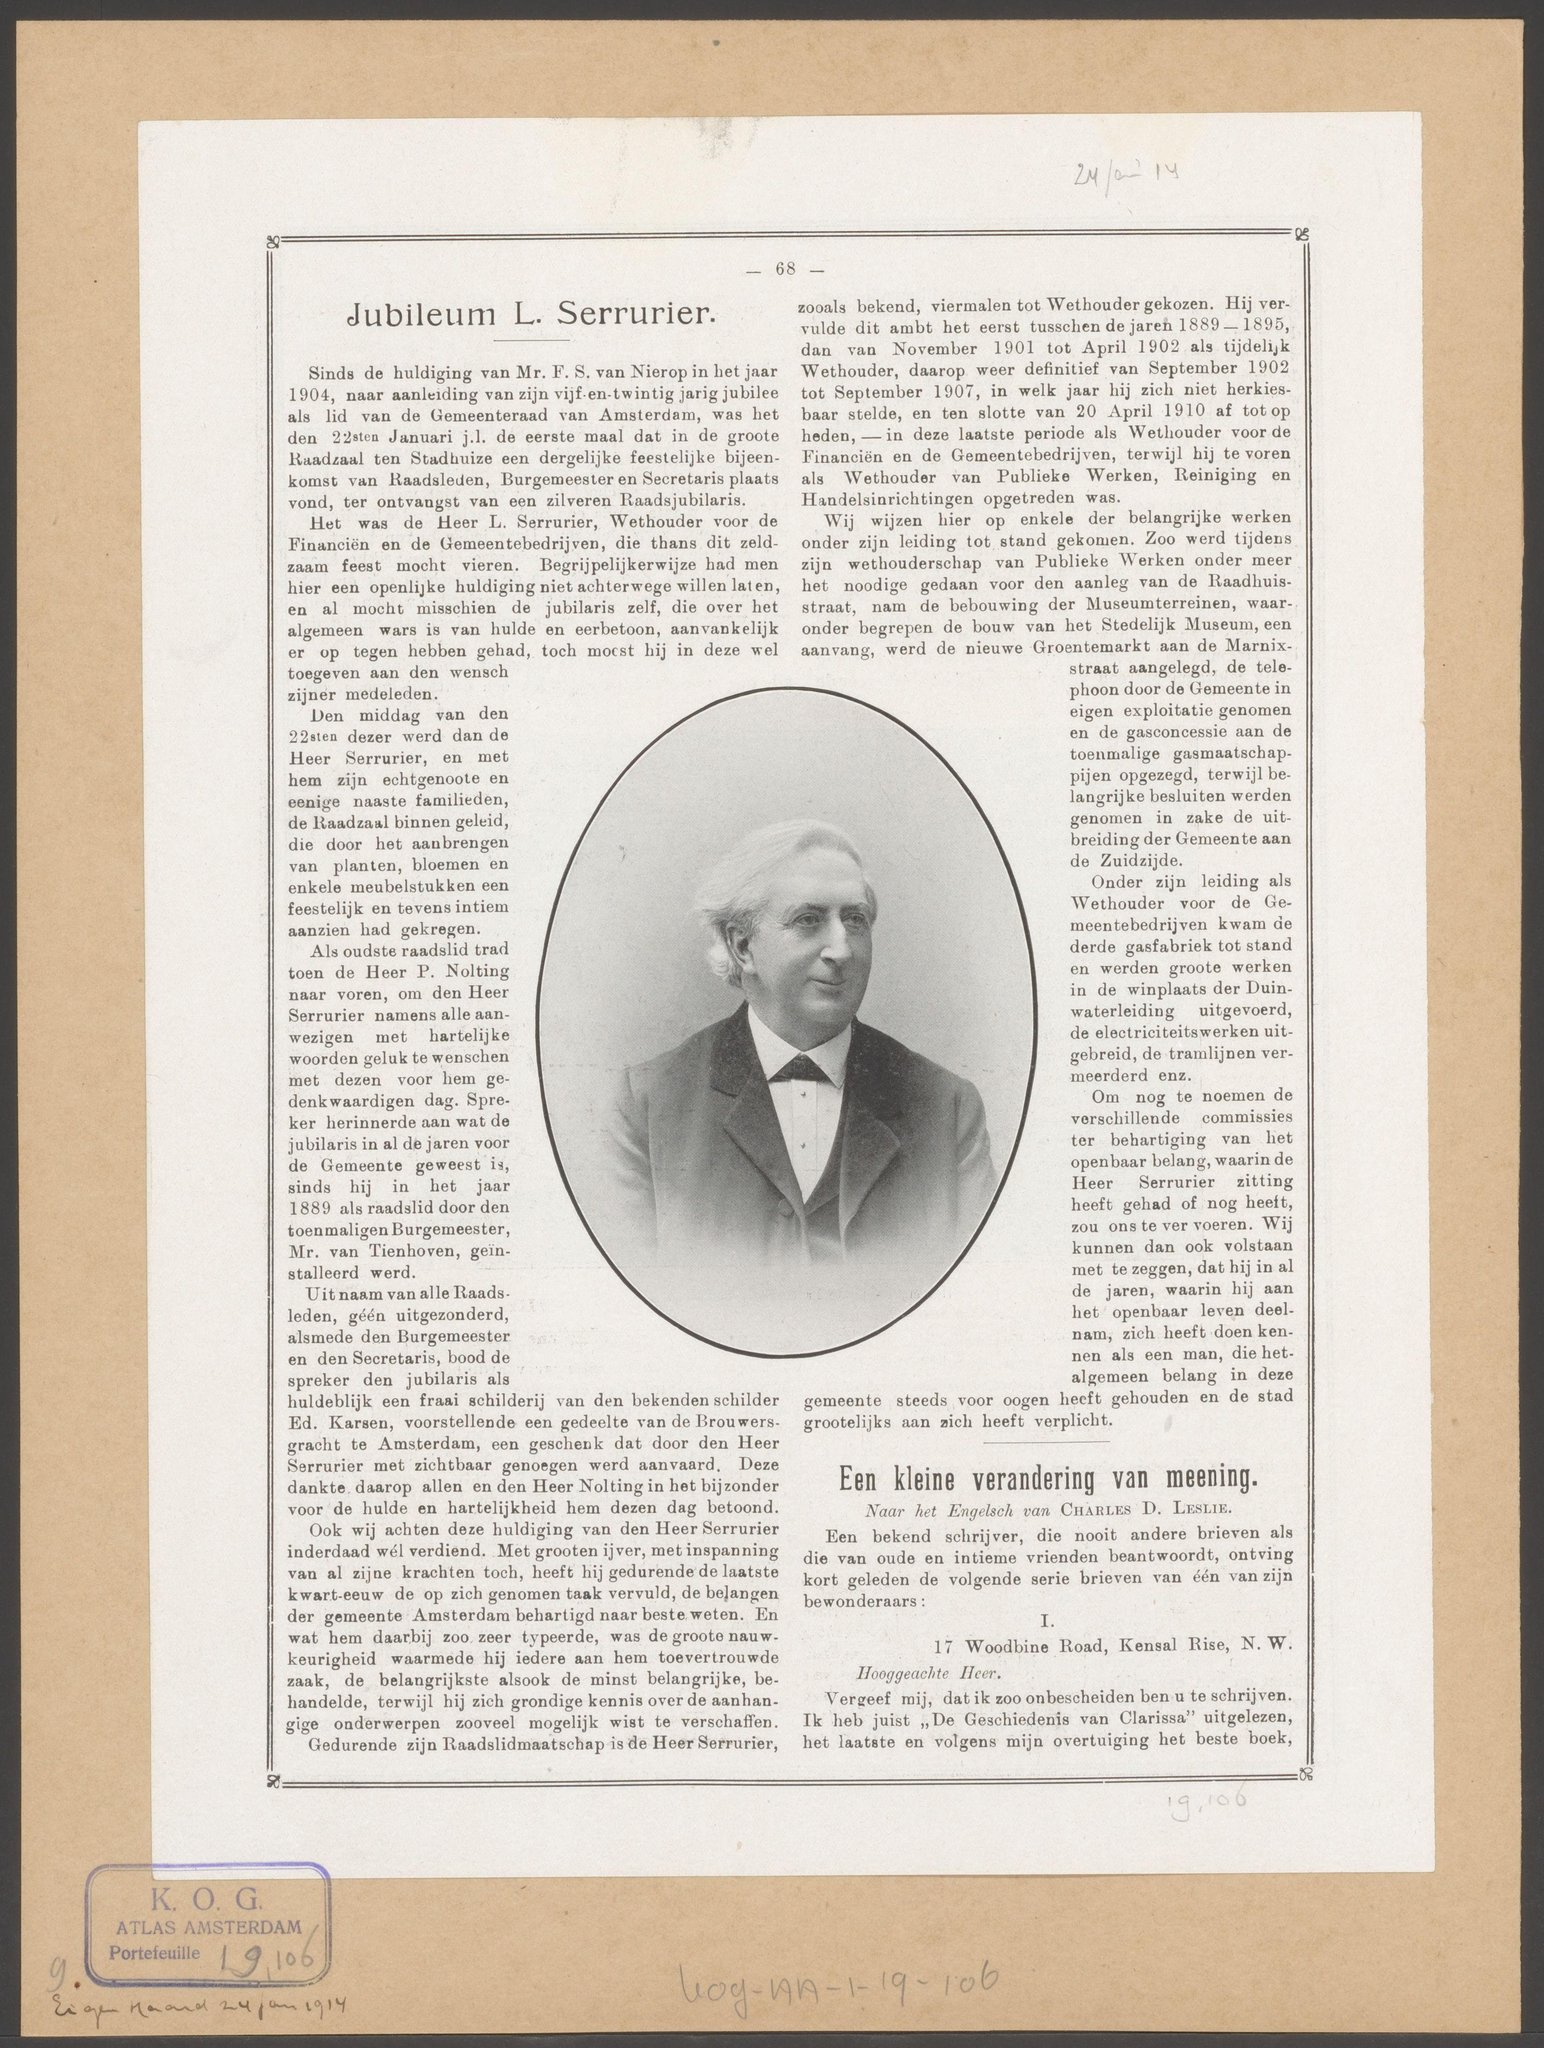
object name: page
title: Beschrijving van de carrière van L. Serrurier naar aanleiding van zijn 25 jarig jubileum als raadslid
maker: Anonymous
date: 1914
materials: paper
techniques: letterpress printing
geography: haarlem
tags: historical persons, politician, e.g. party leader, amsterdam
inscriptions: collector's mark: ‘19,106’ Lugt 1641b, date: ‘24 Jan '14’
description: Onderwerpsrubriek binnen de Atlas Amsterdam: Herinneringen aan regeringsleden en hunne huisgezinnen [na 1800].